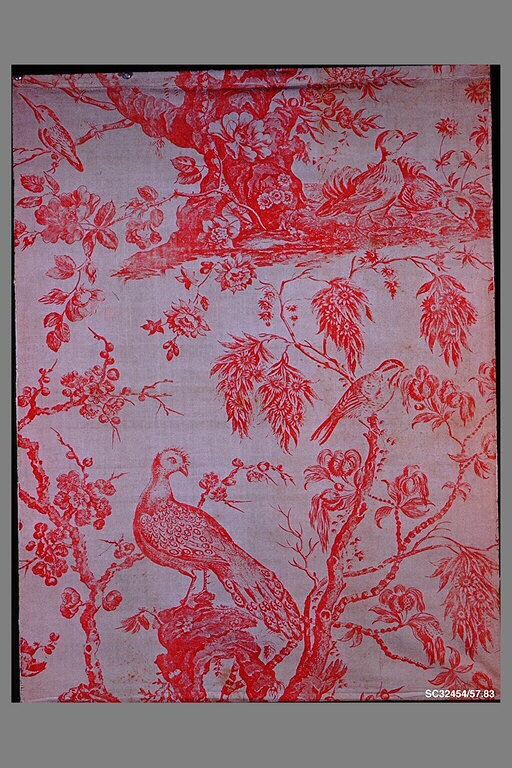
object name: piece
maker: bromley hall printworks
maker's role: manufactory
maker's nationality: english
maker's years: 1694-1823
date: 1785-1790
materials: cotton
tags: birds,flowers,trees